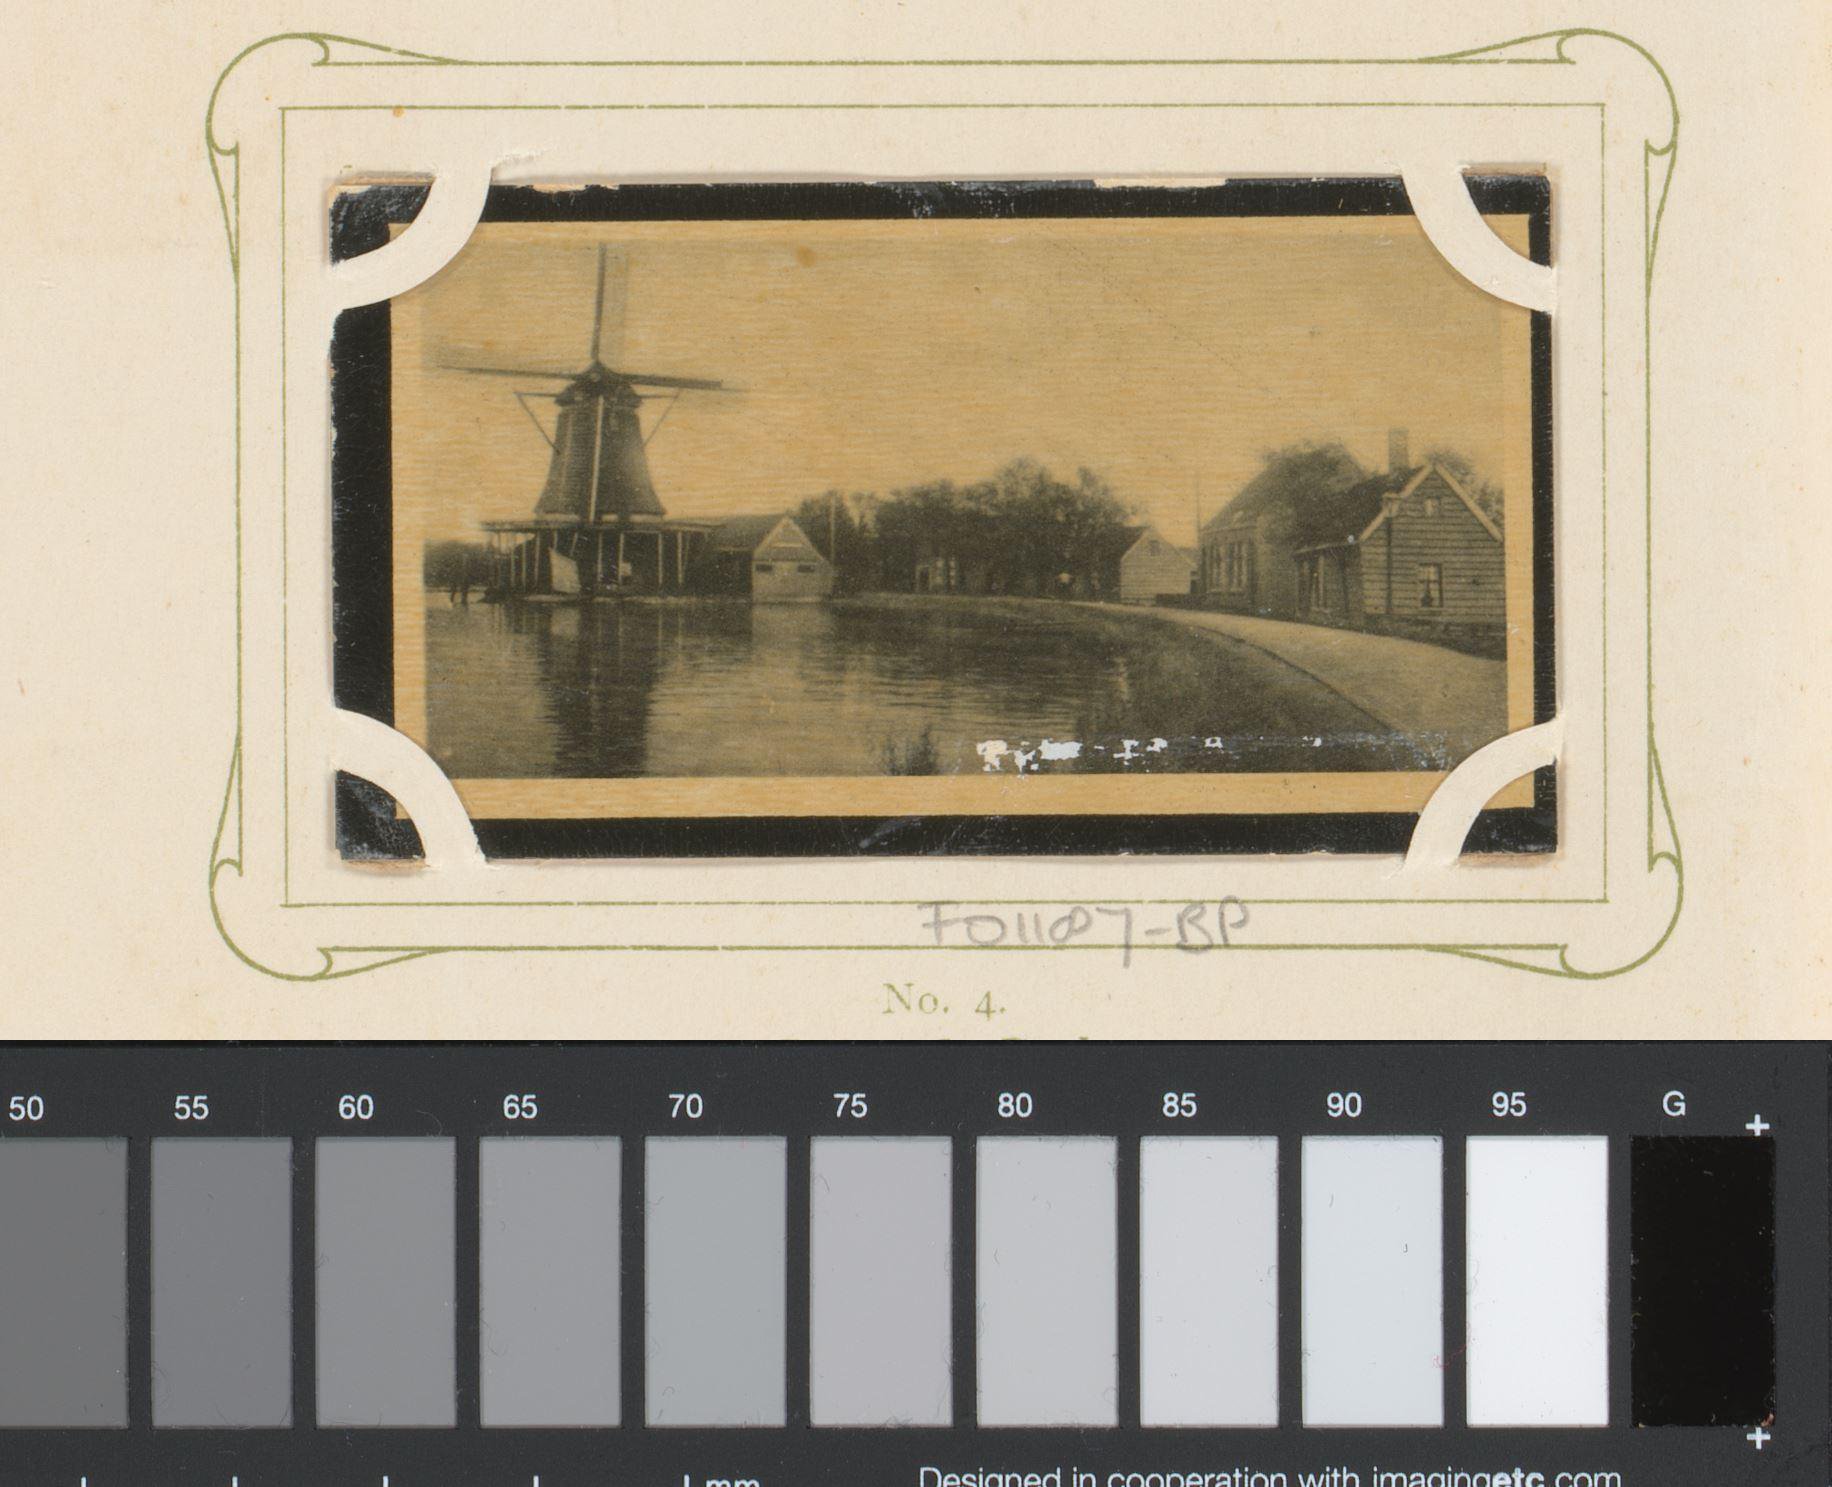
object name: album leaf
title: Gezicht op de Poel in Zaandam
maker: Anonymous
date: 1905-1906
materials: paper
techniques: photograph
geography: zaandam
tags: prospect of village, silhouette of village, lake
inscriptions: inscription: ‘No. 4./ Langs de Poel.’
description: Deze prent maakt deel uit van een album.